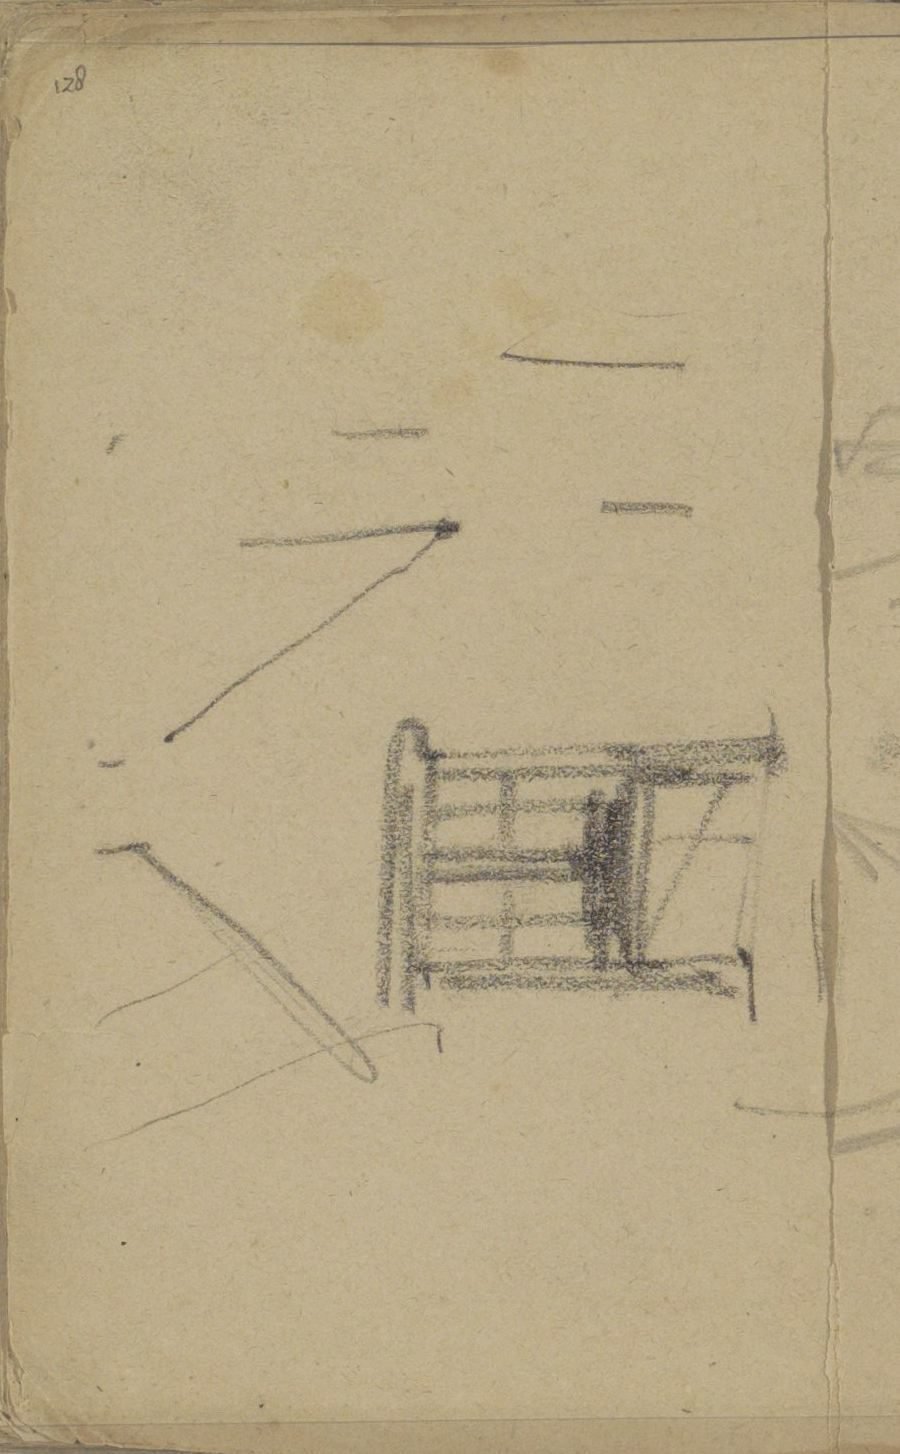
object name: sketchbook leaf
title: Gevel met een raam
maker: george hendrik breitner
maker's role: draughtsman, painter, print maker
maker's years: 1857-1923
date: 1881-1883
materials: chalk, paper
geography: south holland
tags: window, façade (of house or building)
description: Gevel met een raam. Pagina 128 uit een schetsboek met 70 bladen.